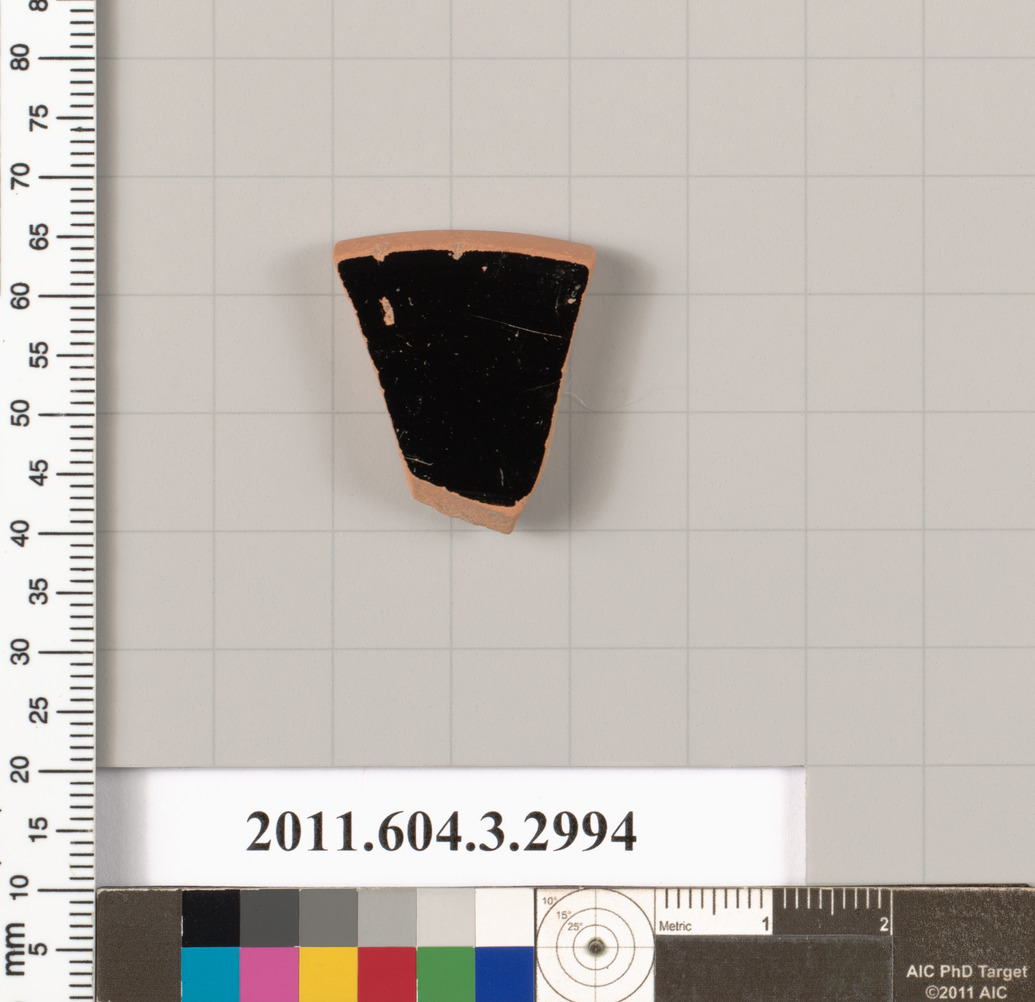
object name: kylix fragment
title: Terracotta fragment of a kylix (drinking cup)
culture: greek, attic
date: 600-401 BCE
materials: terracotta